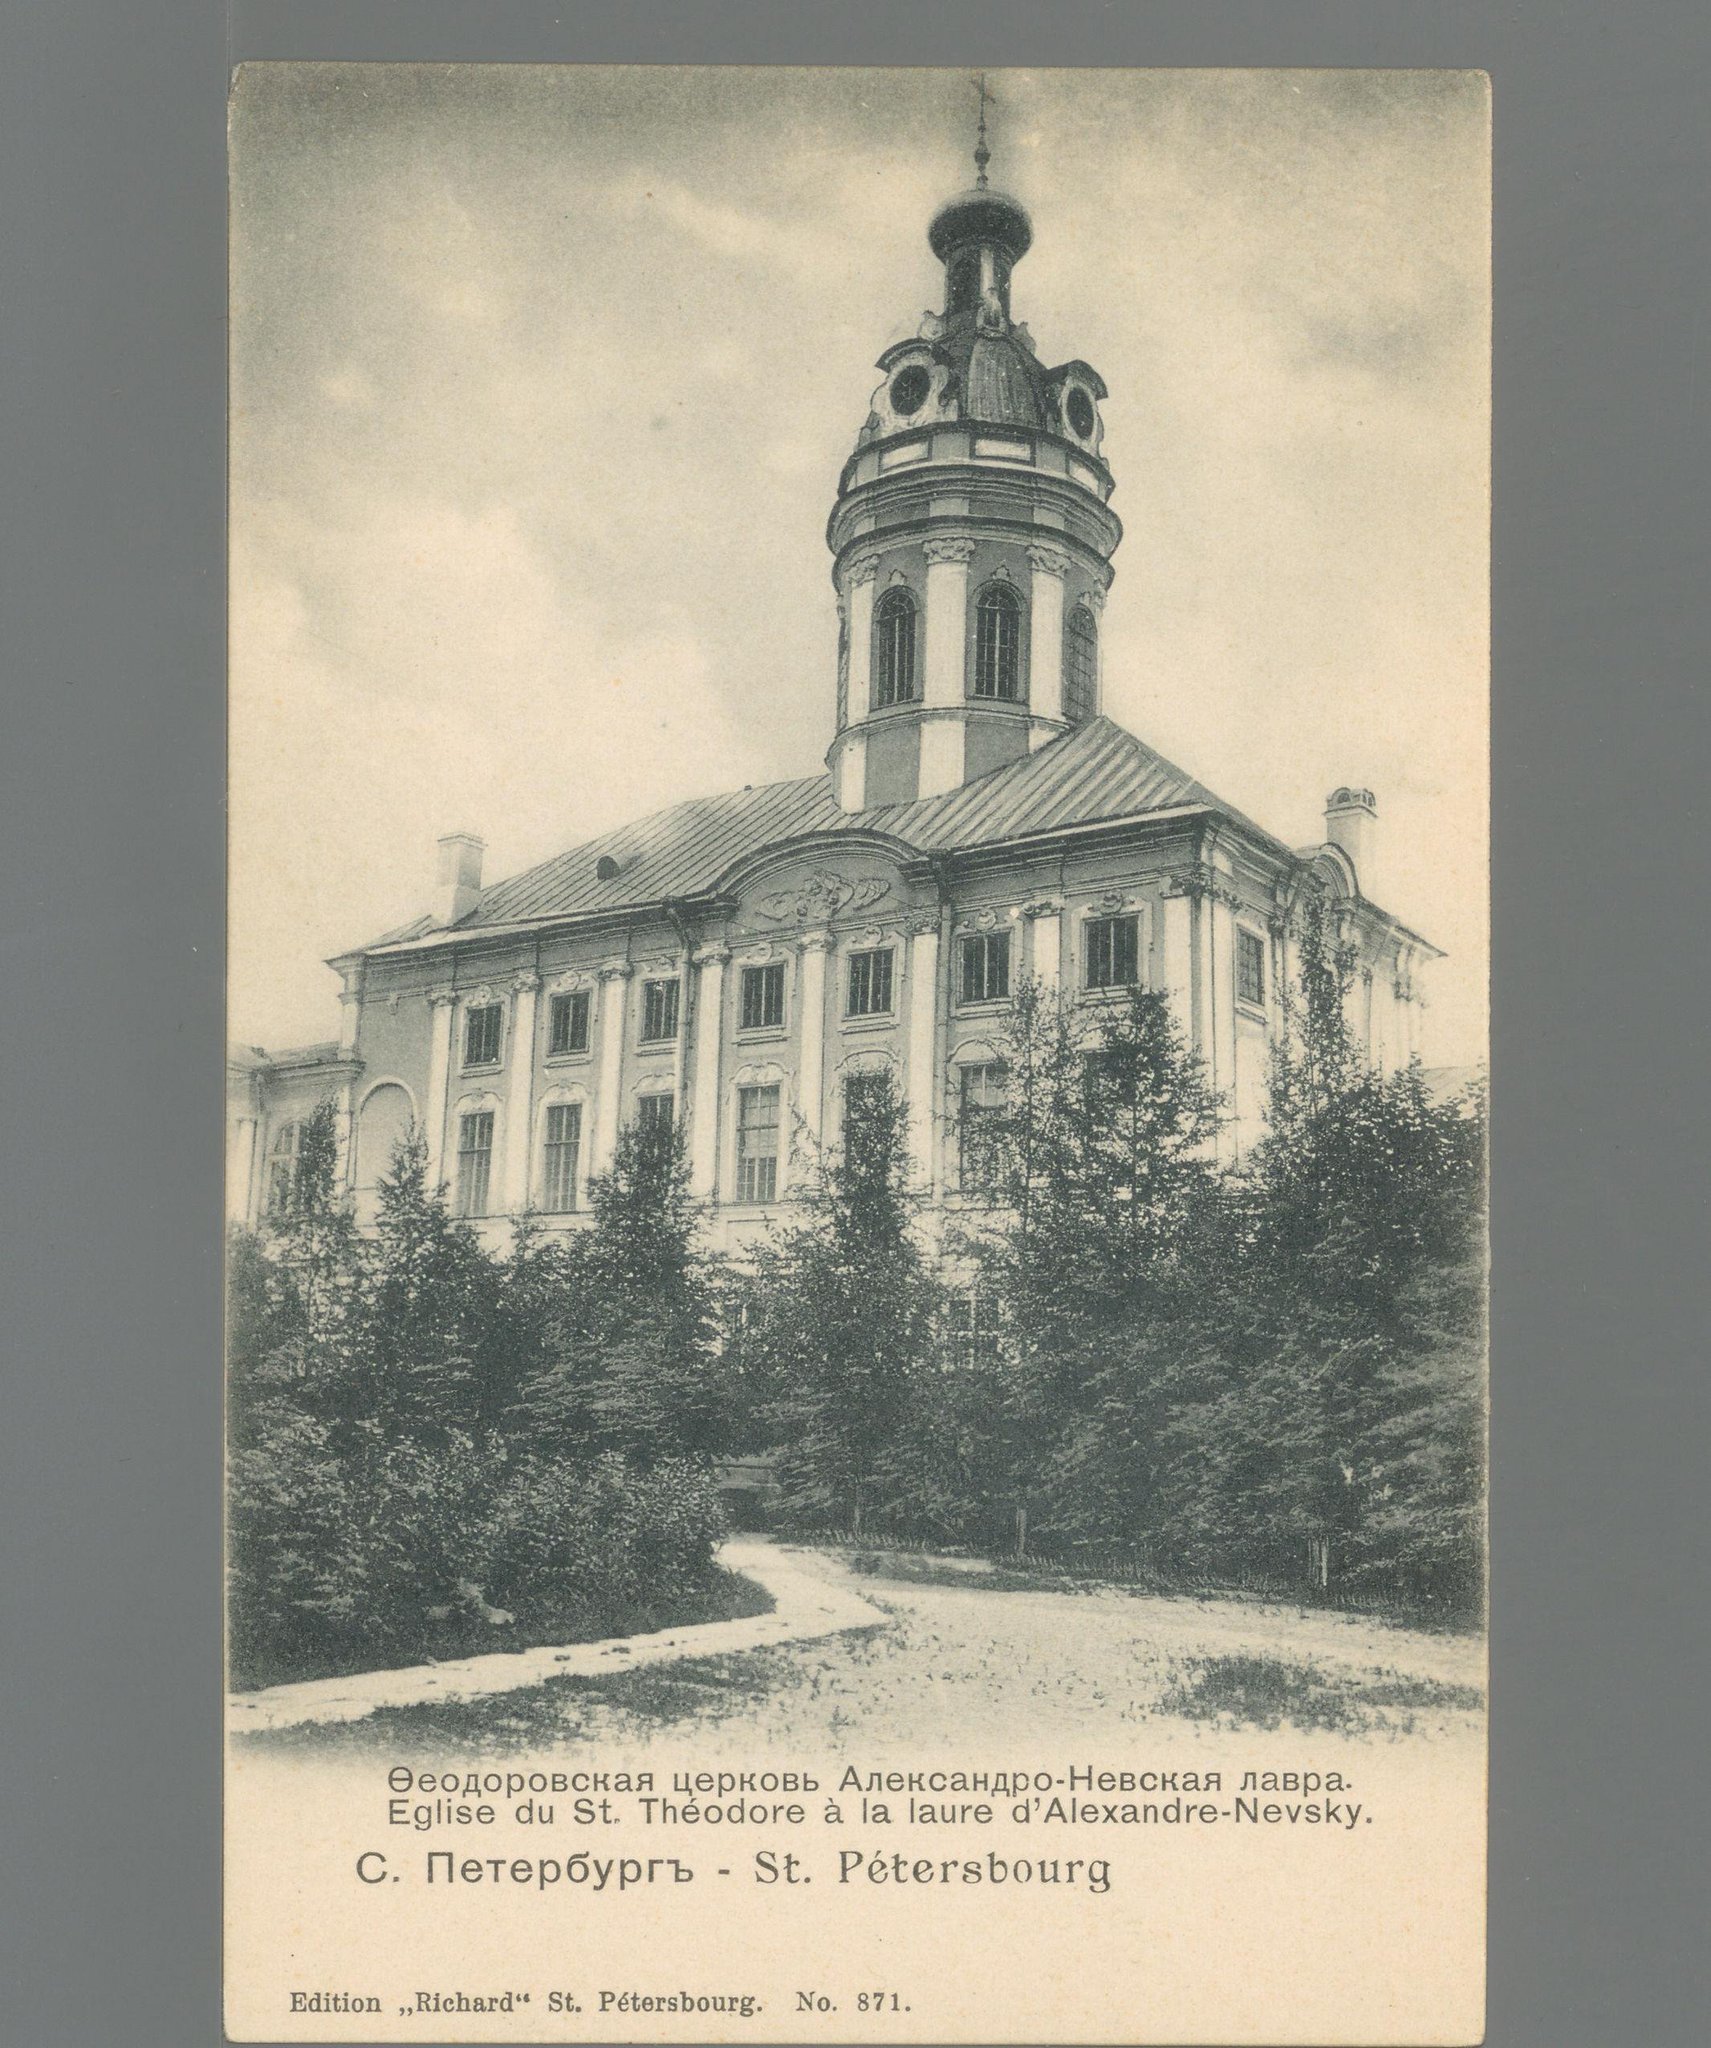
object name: photomechanical print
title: Eglise du St. Théodore à la laure d'Alexandre-Nevsky. St. Pétersbourg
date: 1890-1904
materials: cardboard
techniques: photograph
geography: sint-petersburg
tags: church (exterior)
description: Voor de Franse titel staat de titel in het Russisch.